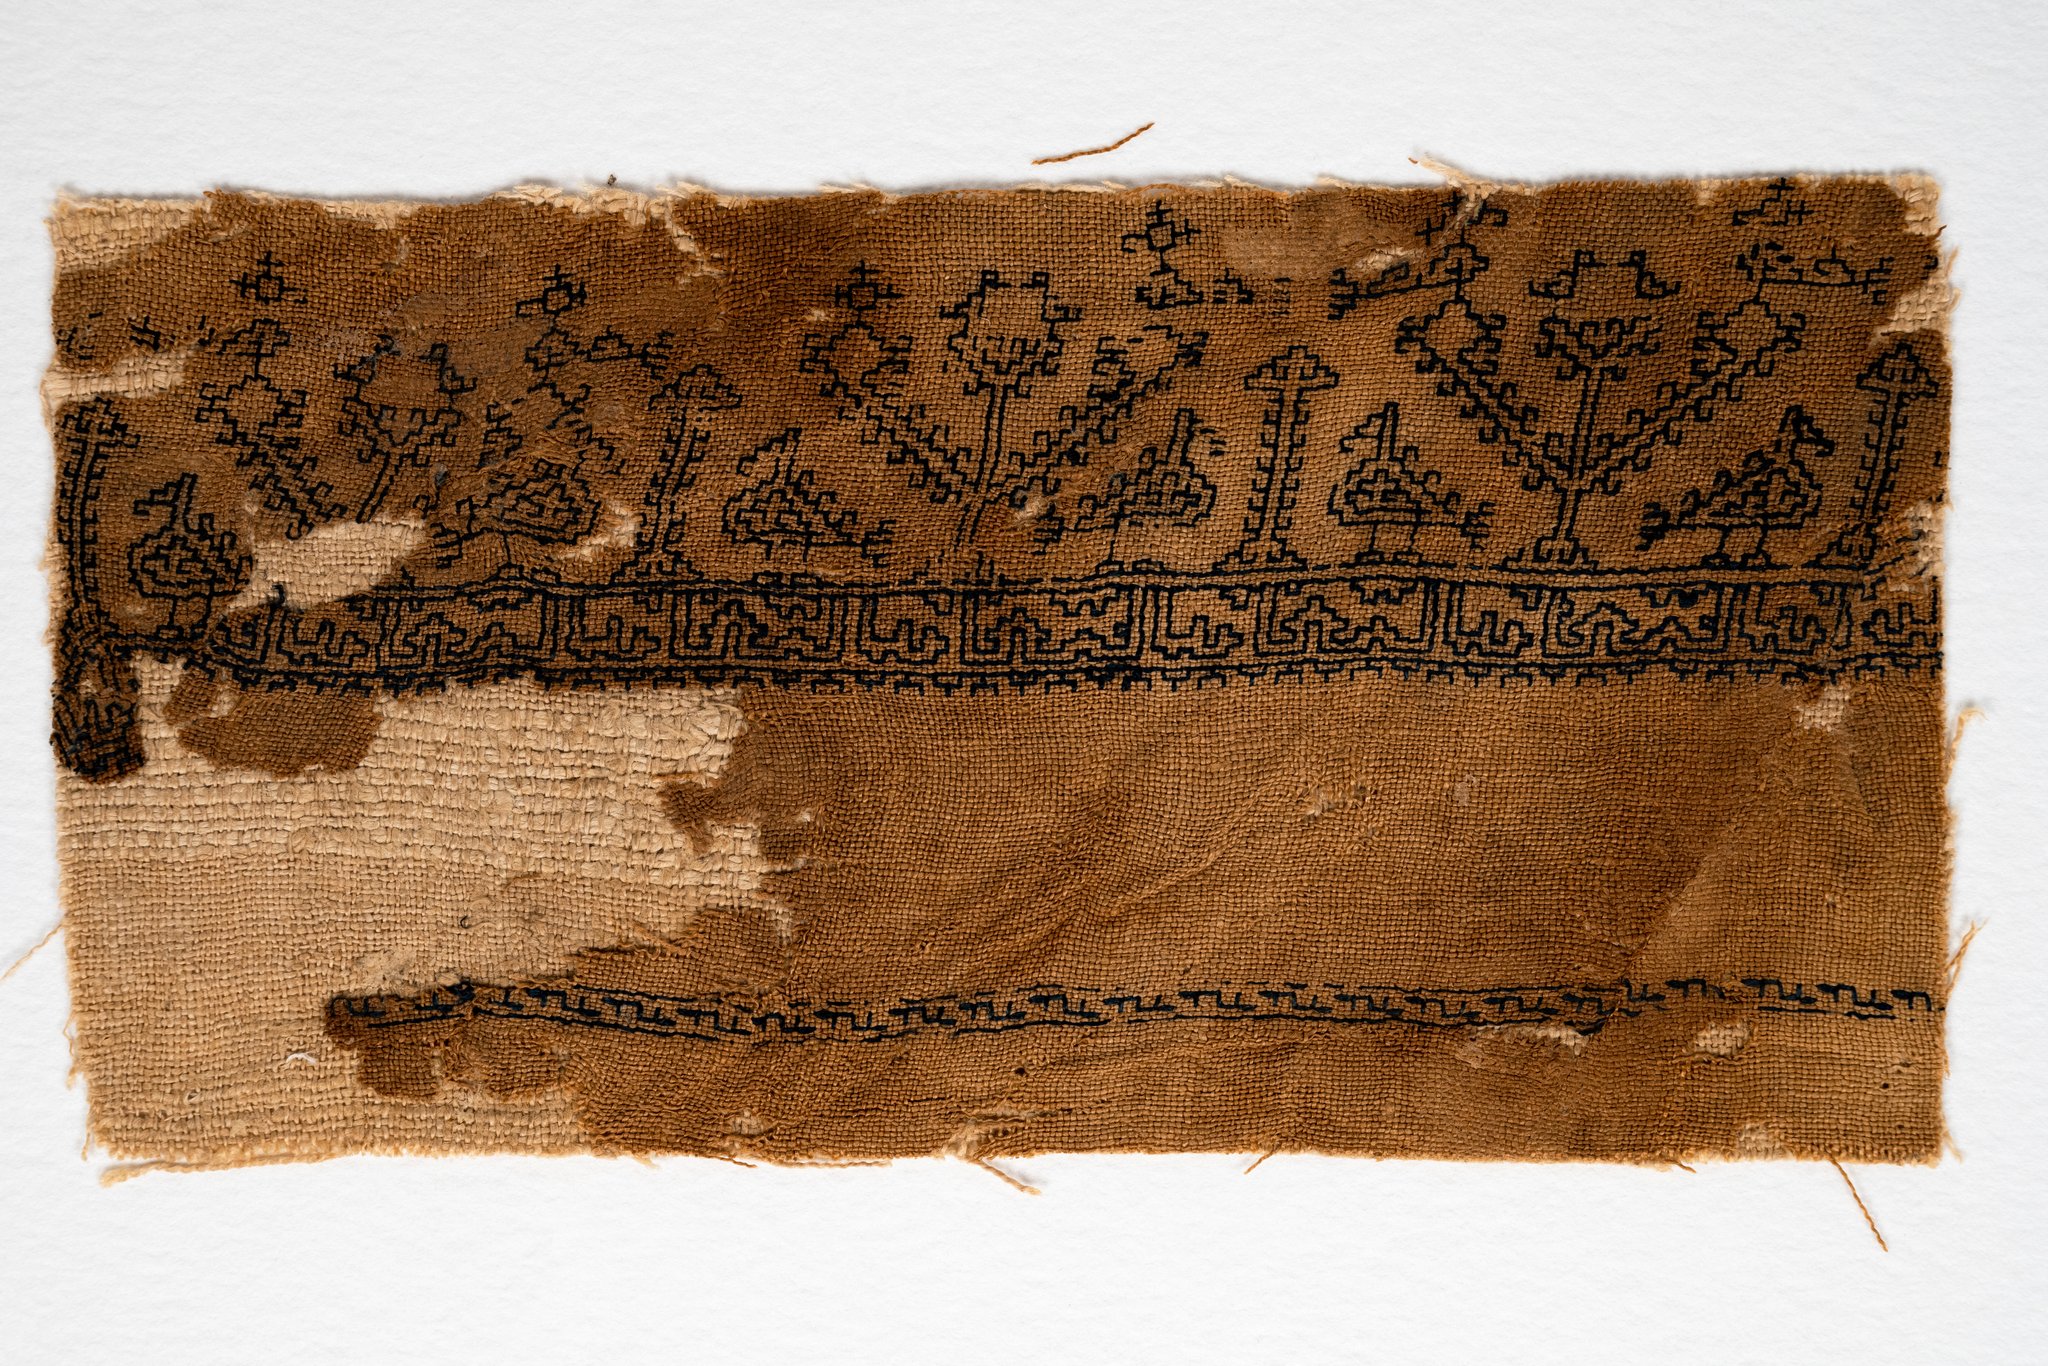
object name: textile fragment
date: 1201-1400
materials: linen, silk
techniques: embroidery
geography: egypt